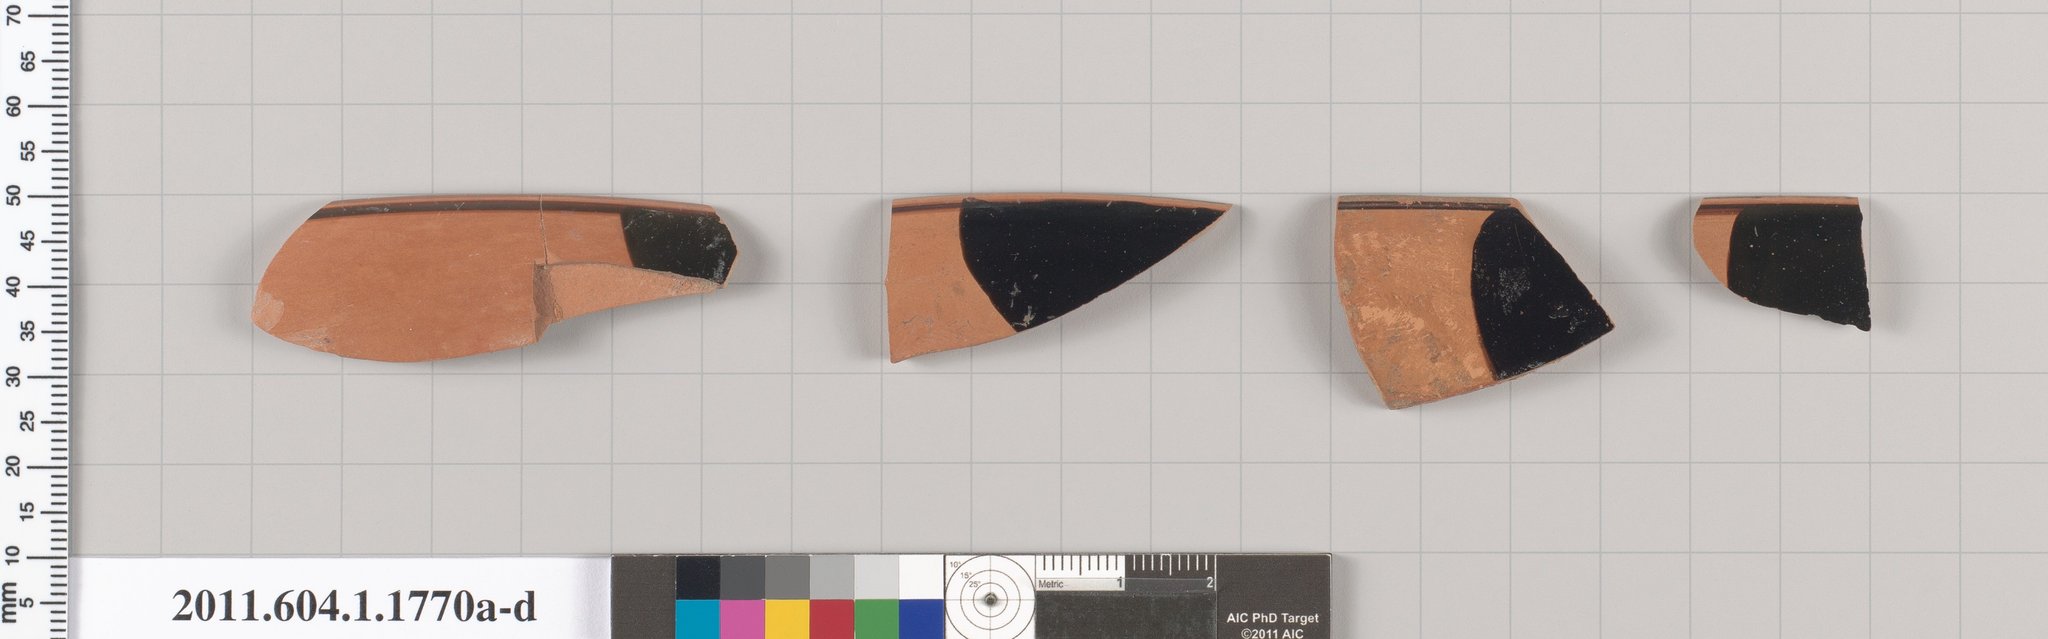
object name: kylix fragment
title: Terracotta rim fragments of kylikes(drinking cups)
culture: greek, attic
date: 500-401 BCE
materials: terracotta